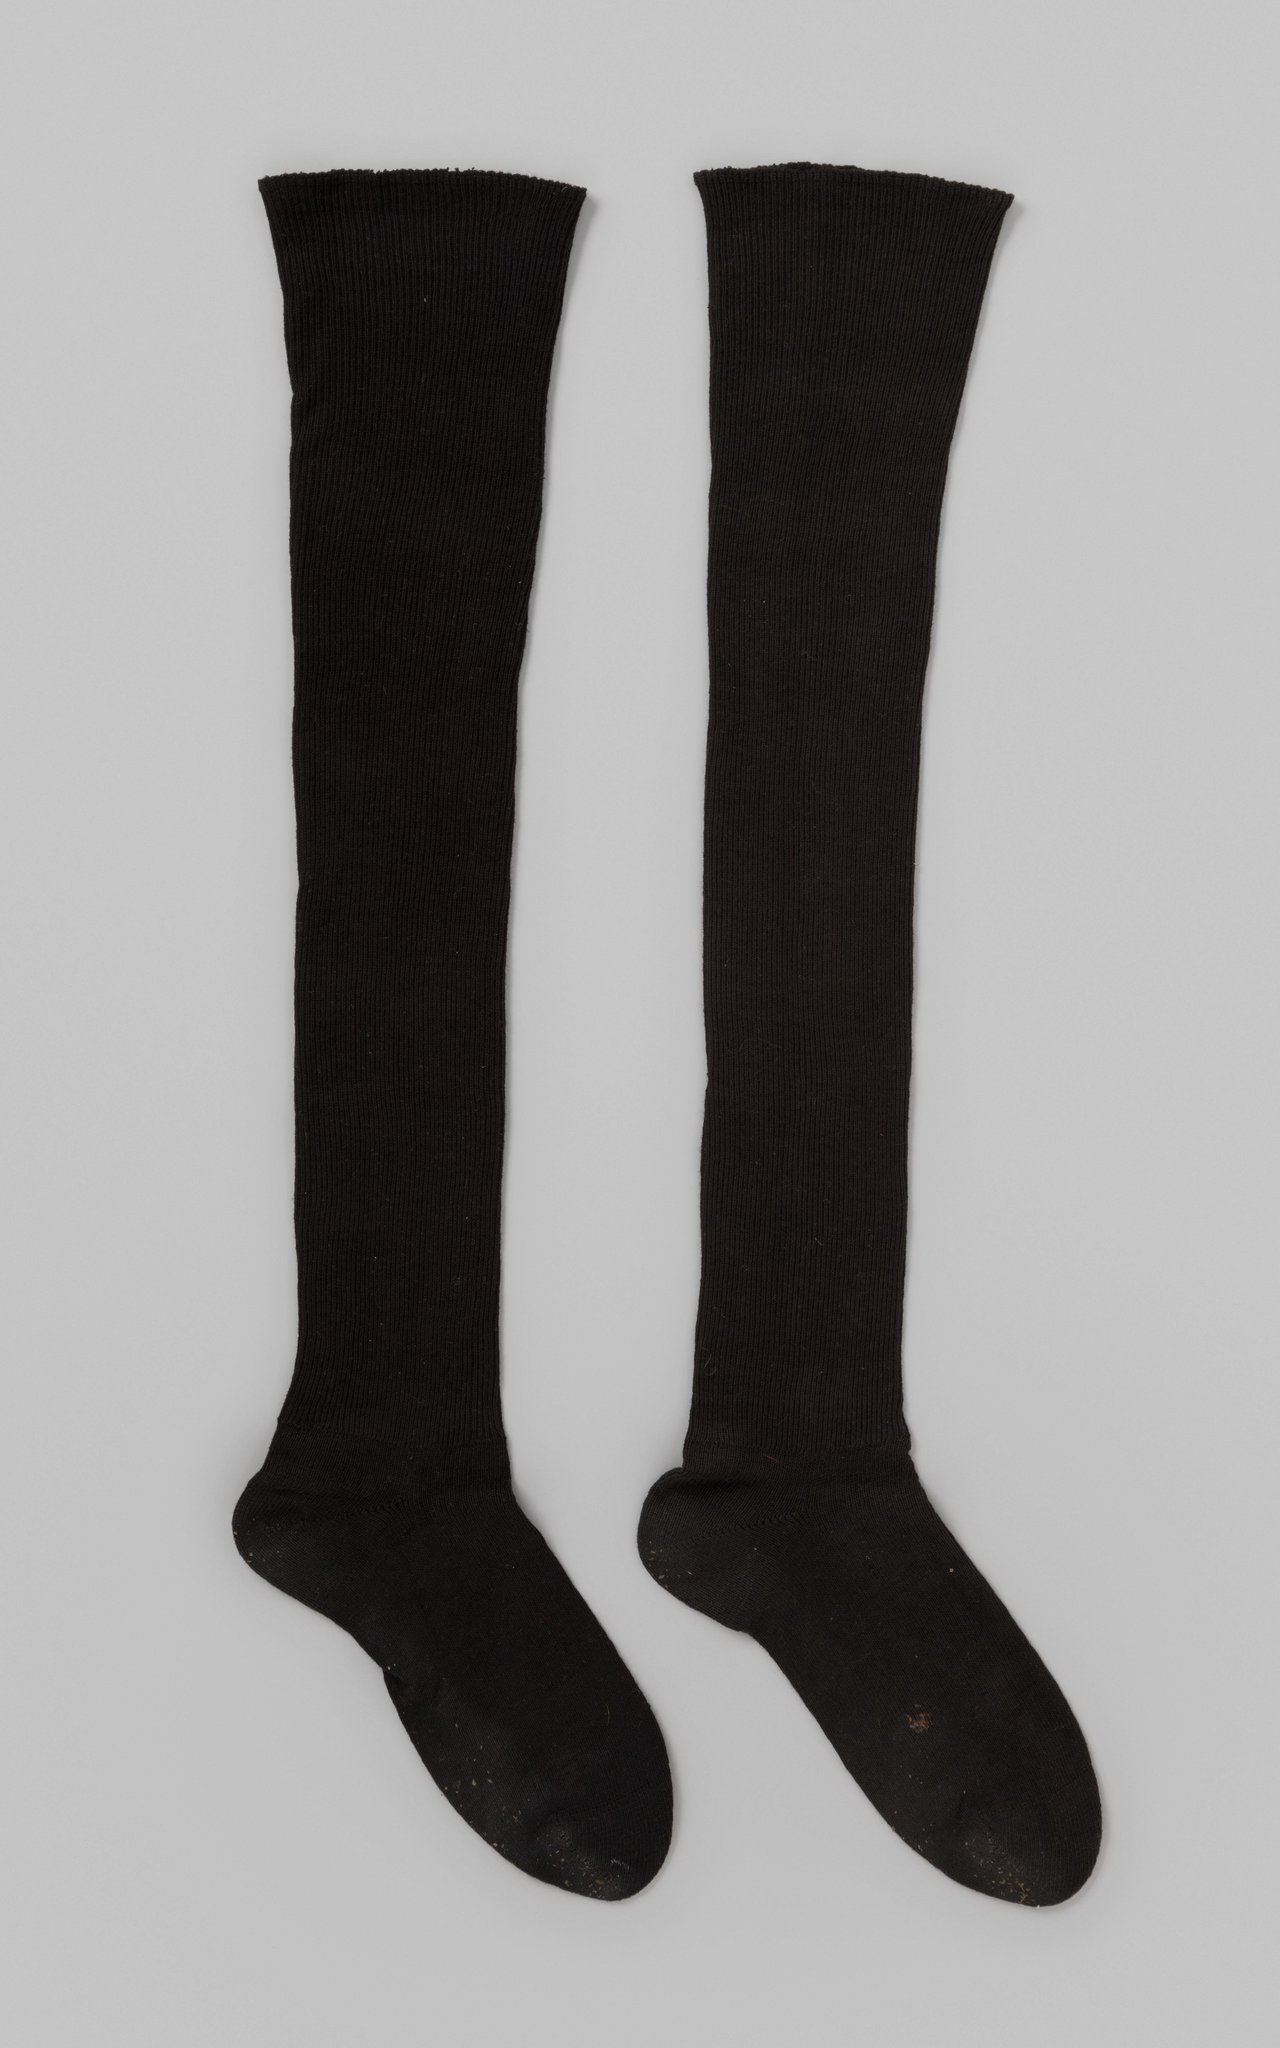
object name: clothing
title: Kous van effen dikke zwarte katoenen tricot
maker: Anonymous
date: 1925-1950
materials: cotton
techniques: knitting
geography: netherlands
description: Kous van zwart katoenen tricot. Vrij grof katoen, naadloos en met zelfkantboord.